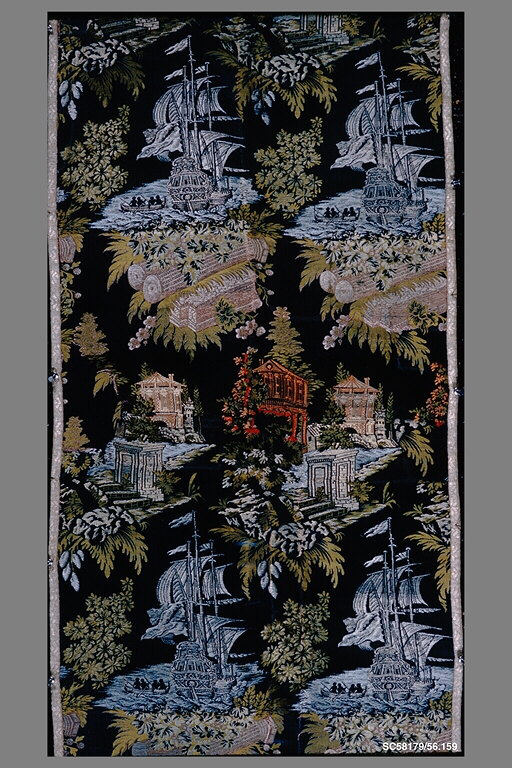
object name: piece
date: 1735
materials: silk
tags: houses,ships